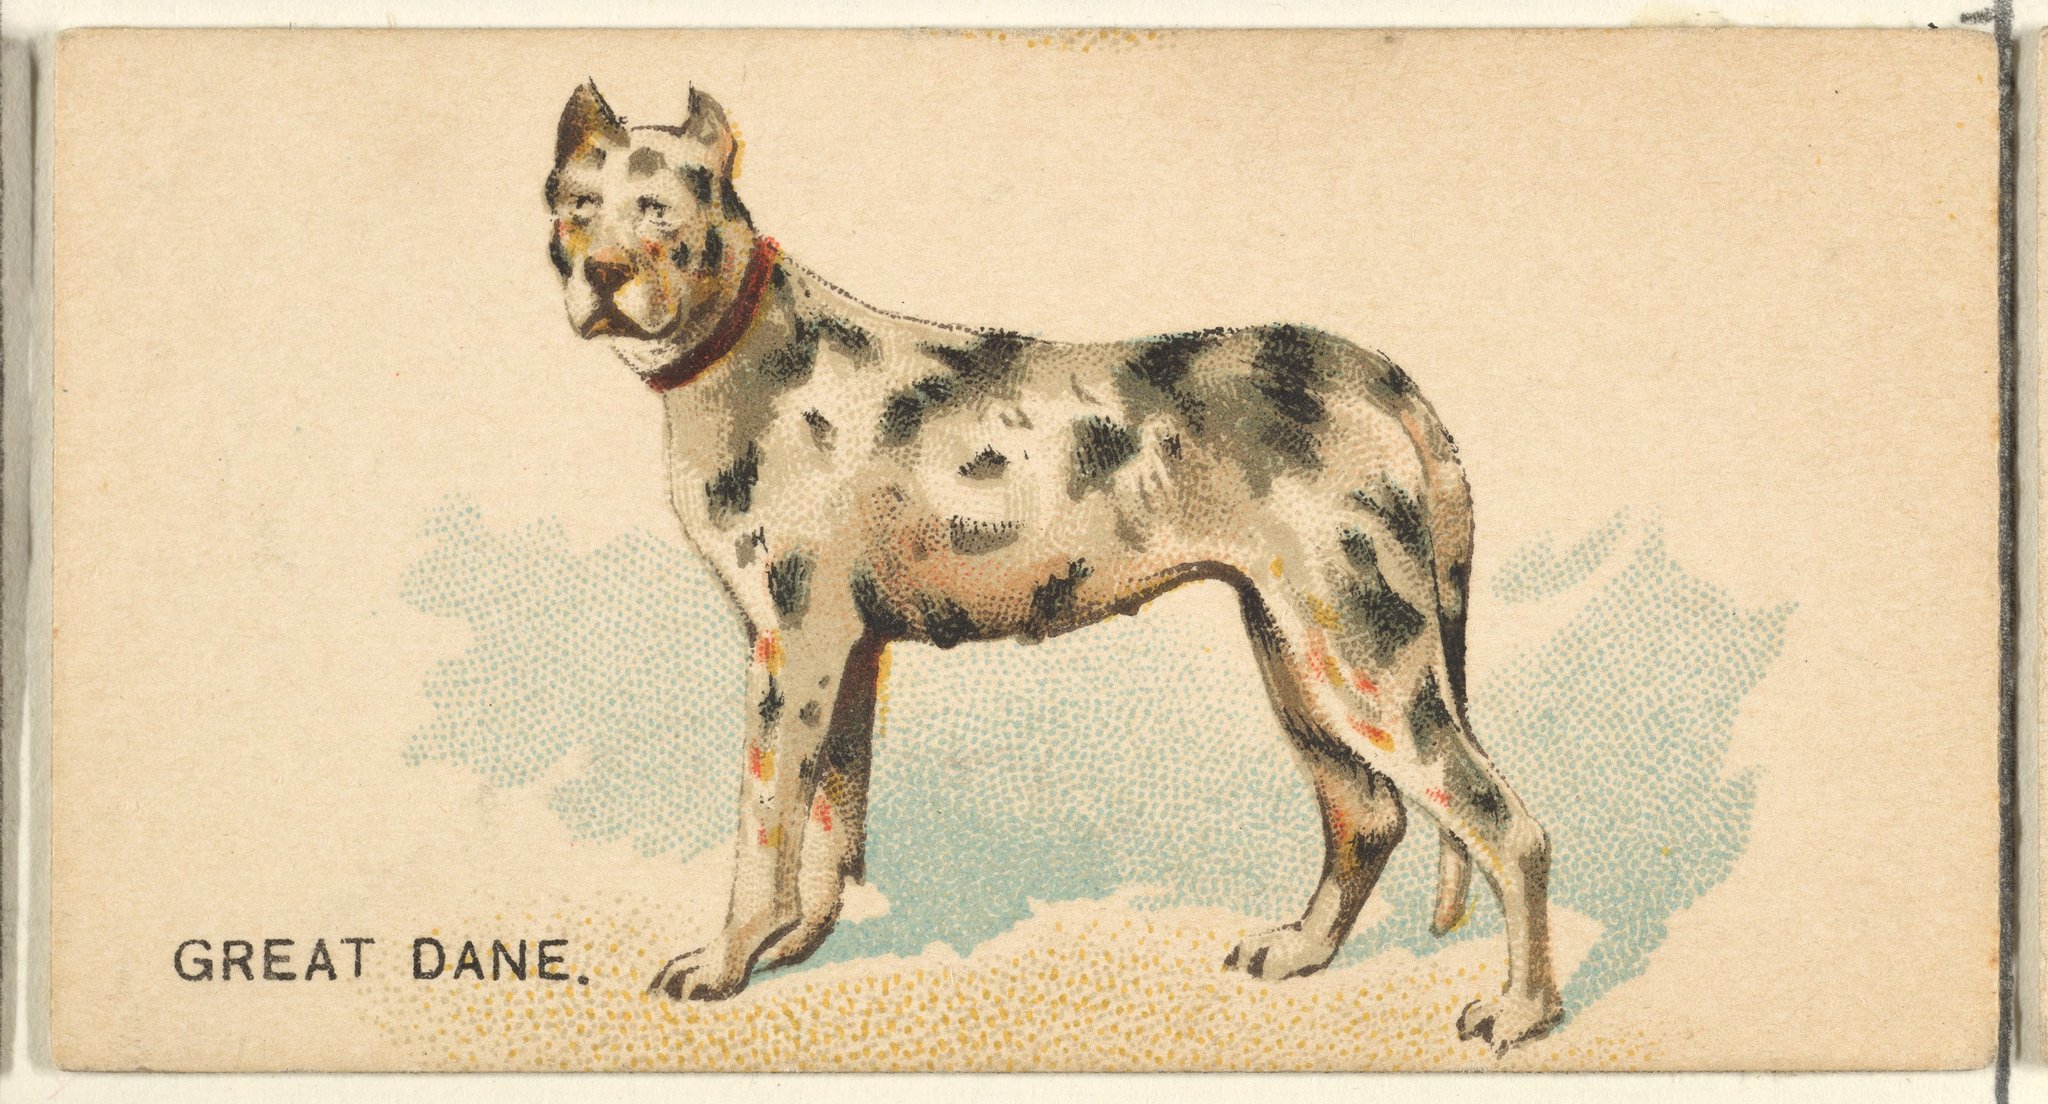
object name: print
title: Great Dane, from the Dogs of the World series for Old Judge Cigarettes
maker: goodwin & company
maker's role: publisher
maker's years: 1850-1950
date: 1890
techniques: color lithograph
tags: dogs